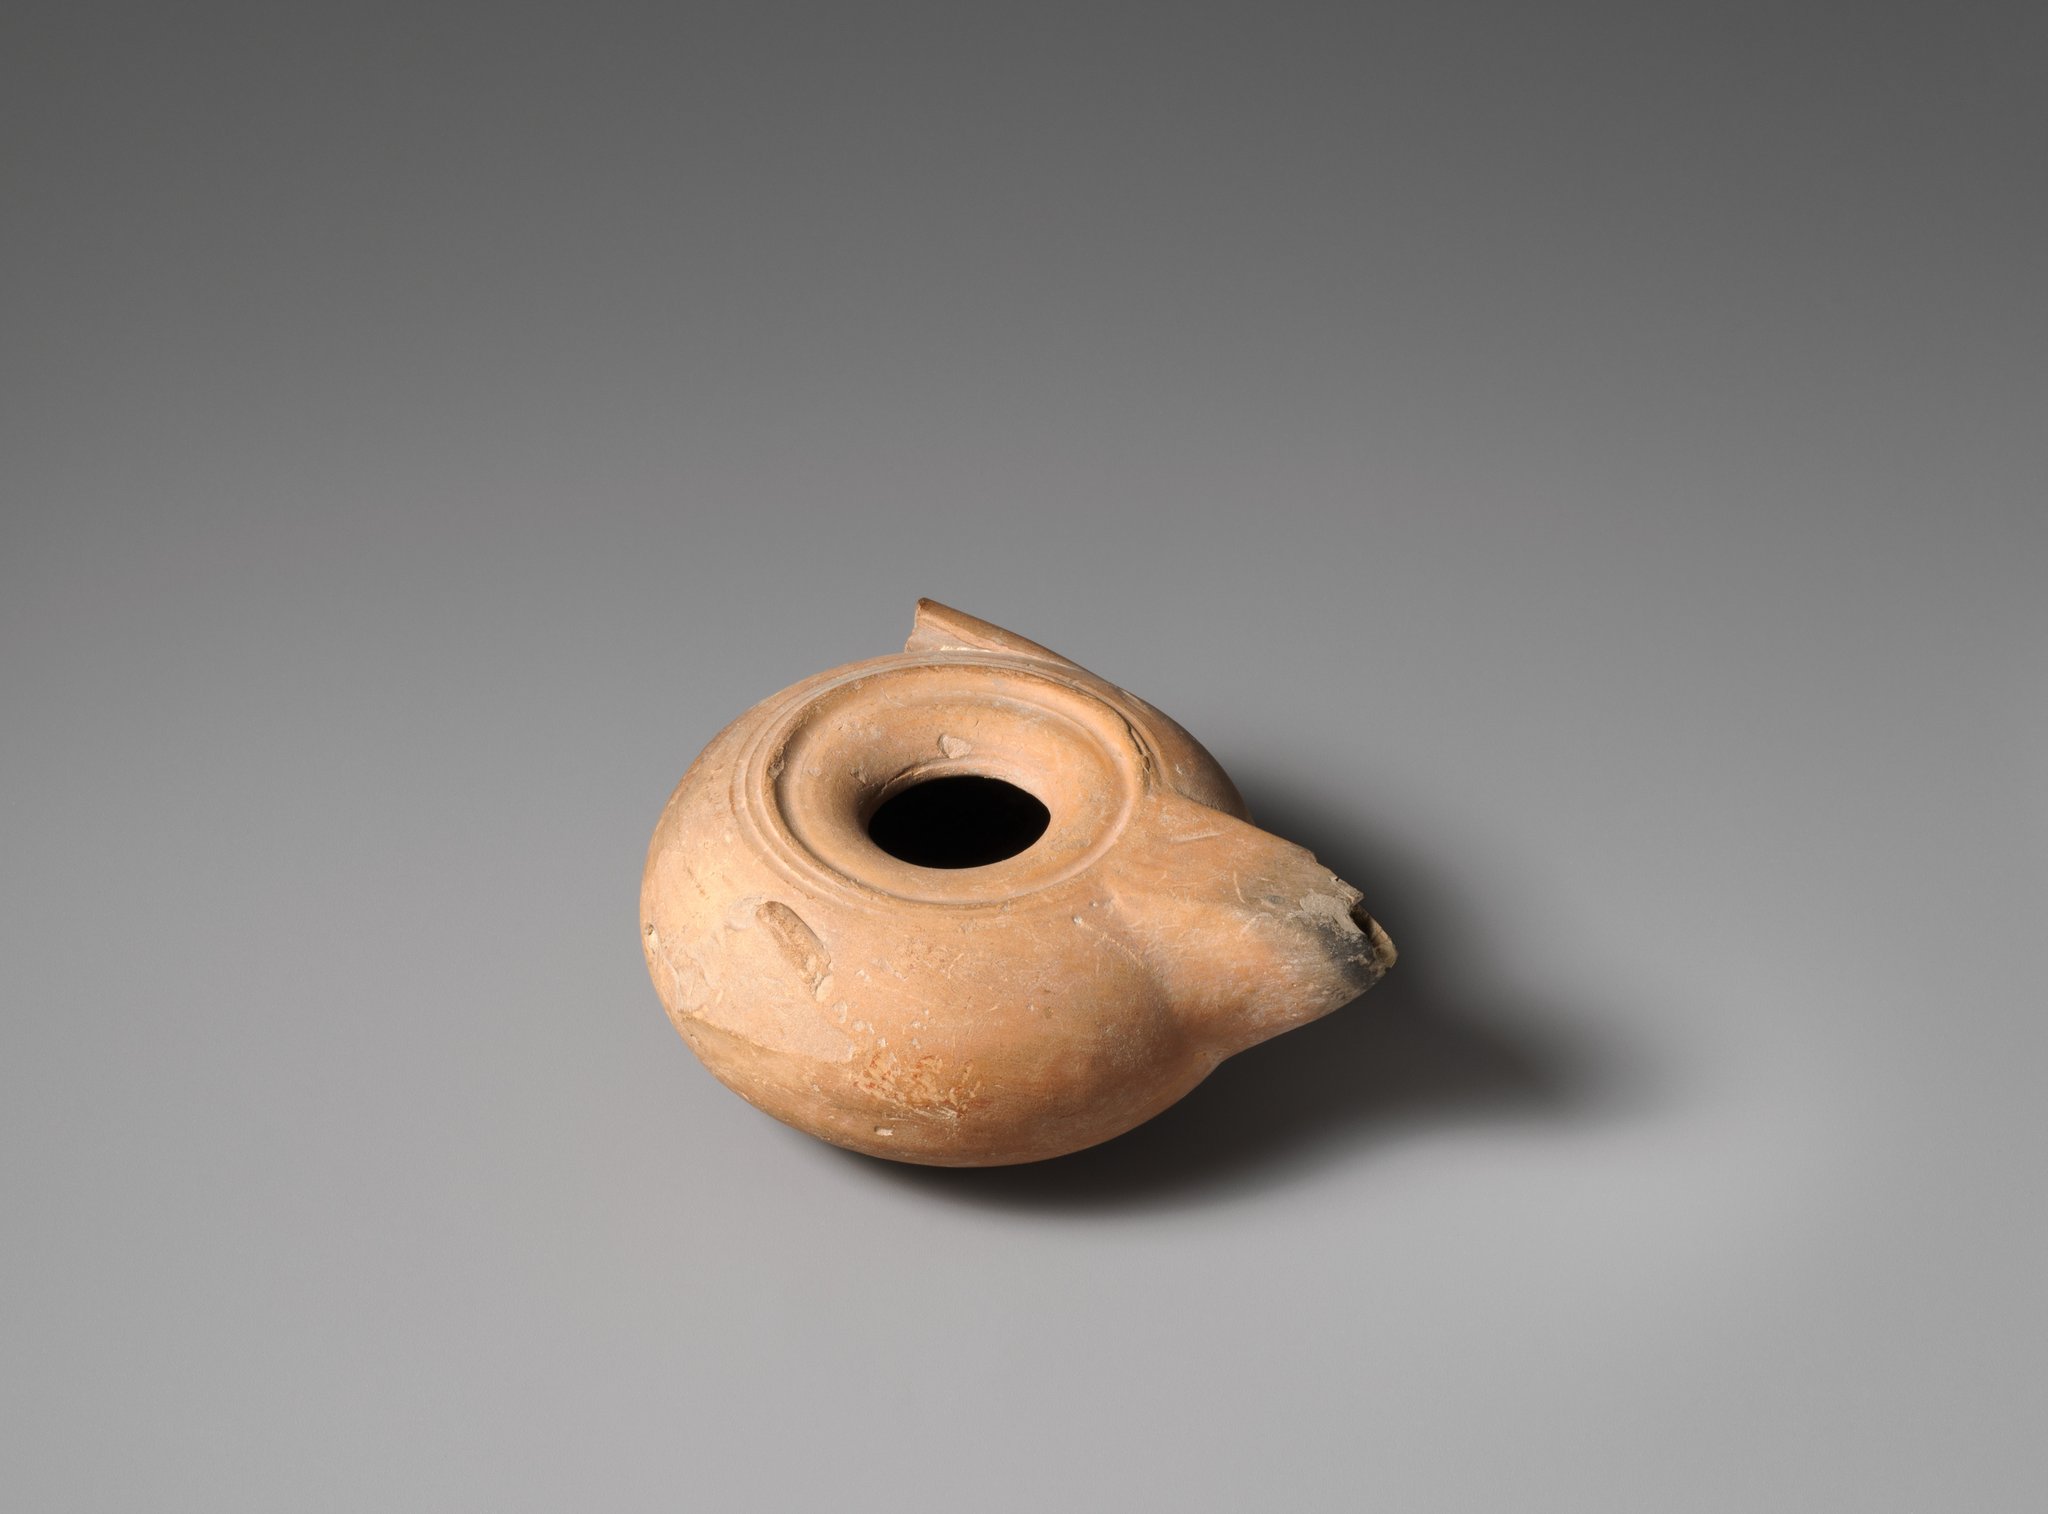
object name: lamp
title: Terracotta oil lamp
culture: greek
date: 350-250 BCE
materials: terracotta